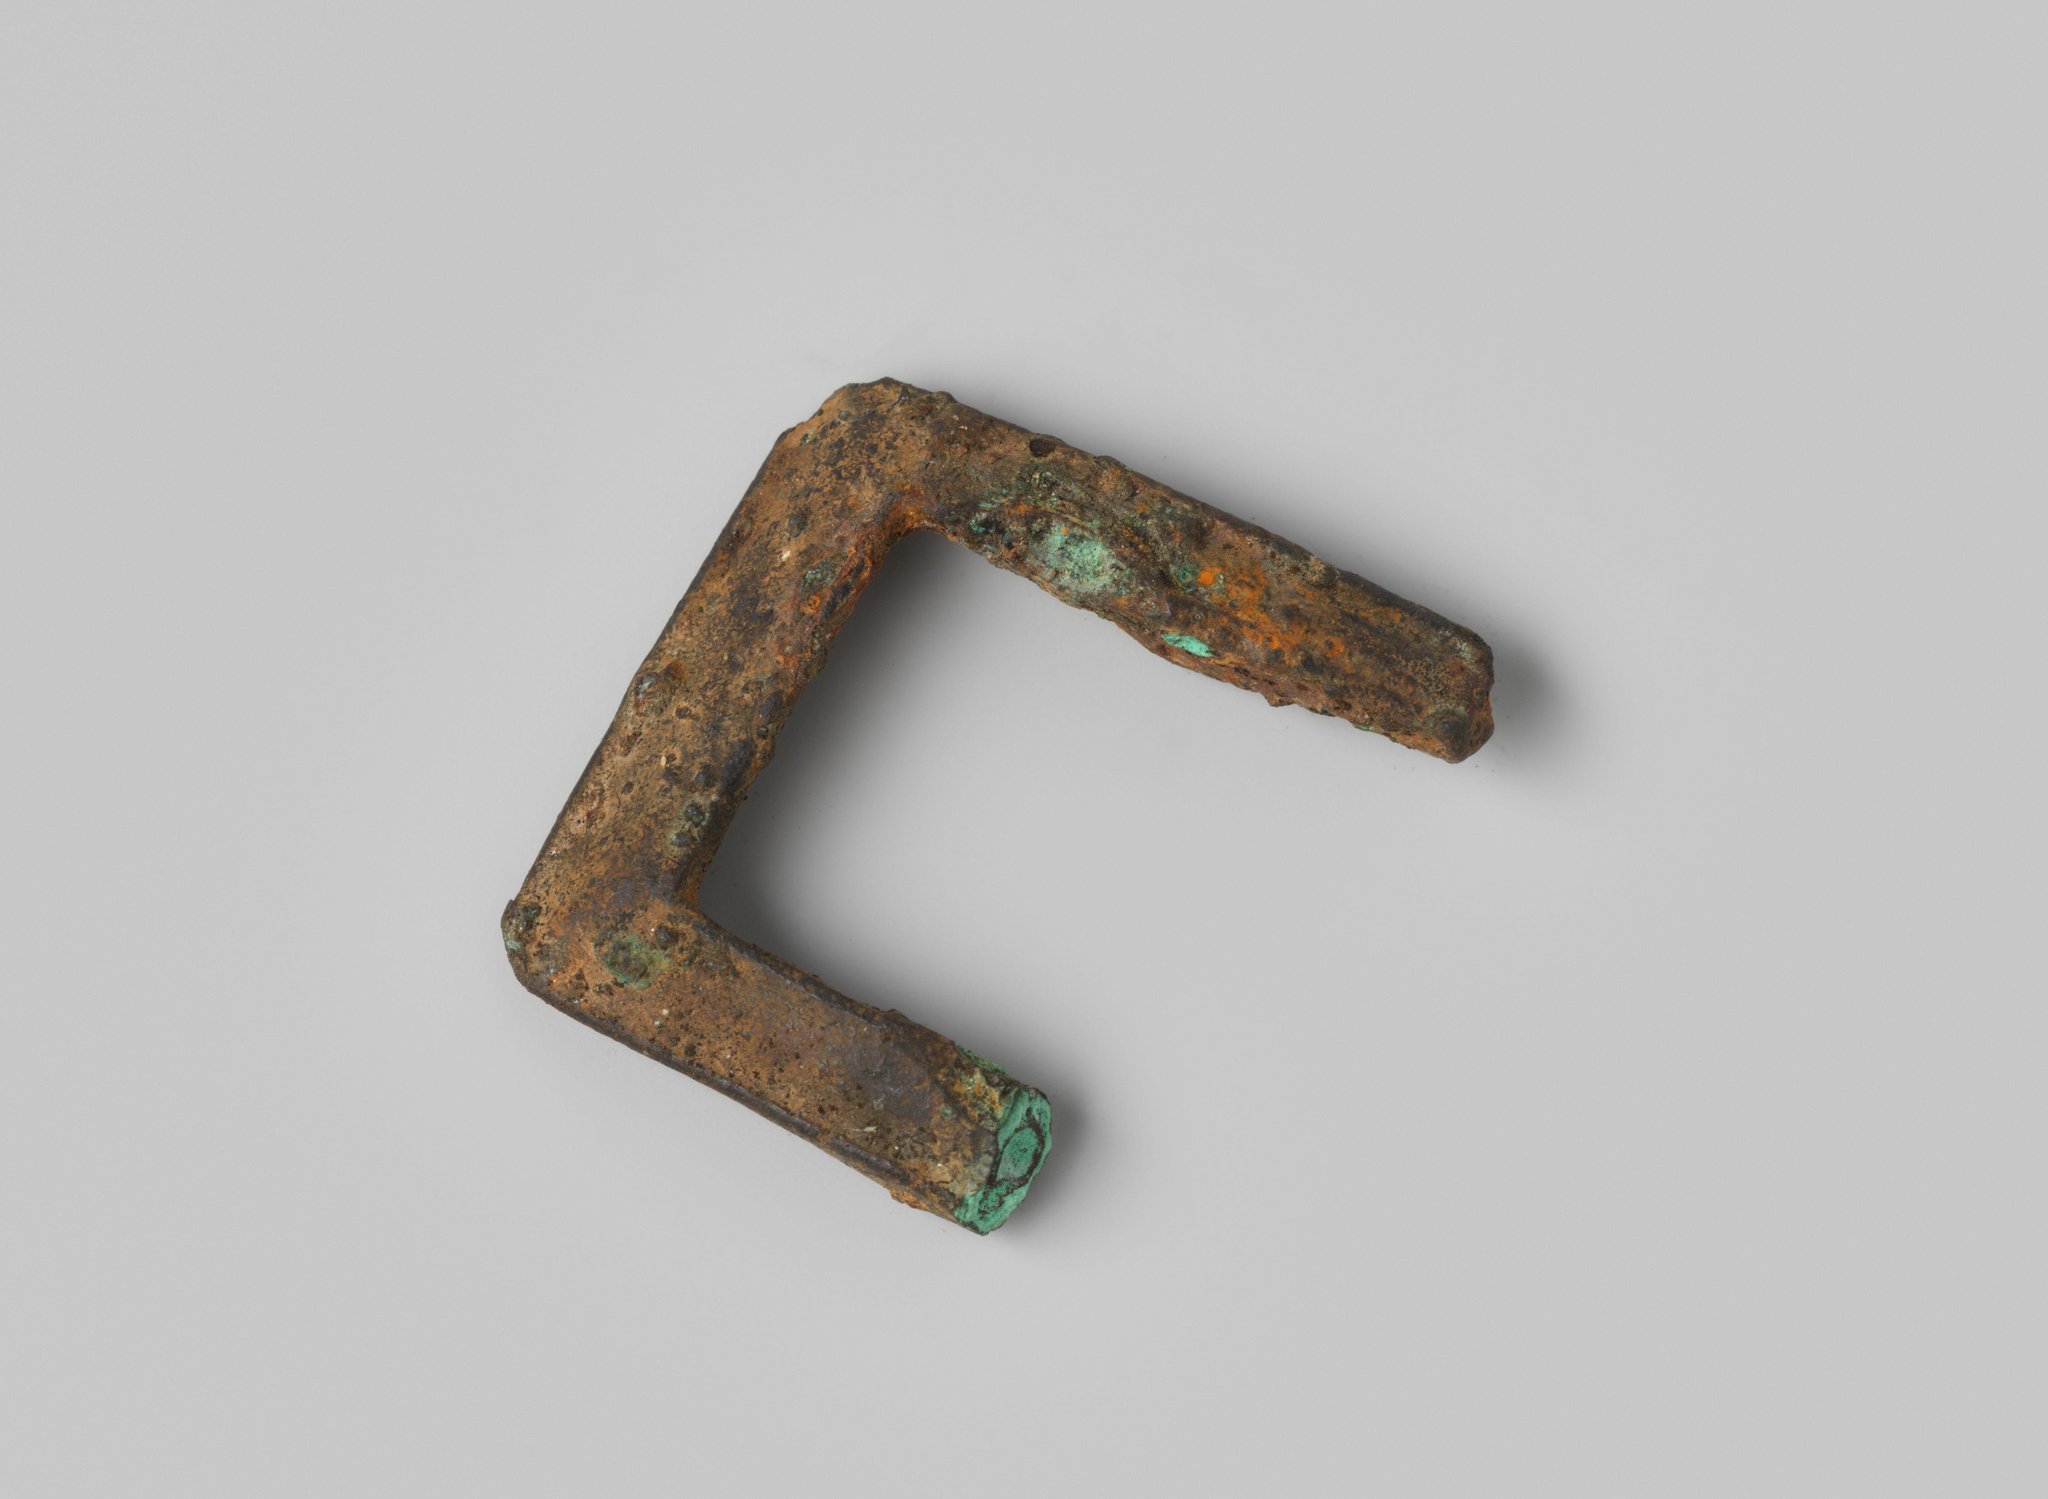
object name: shoe buckle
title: Fragment schoengesp uit het wrak van de Oost-Indiëvaarder Hollandia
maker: Anonymous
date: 1700-1743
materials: copper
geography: netherlands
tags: verenigde oostindische compagnie, hollandia (schip), annet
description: Buckle, chape buckle, shoe buckle; fragment of ring, plain.